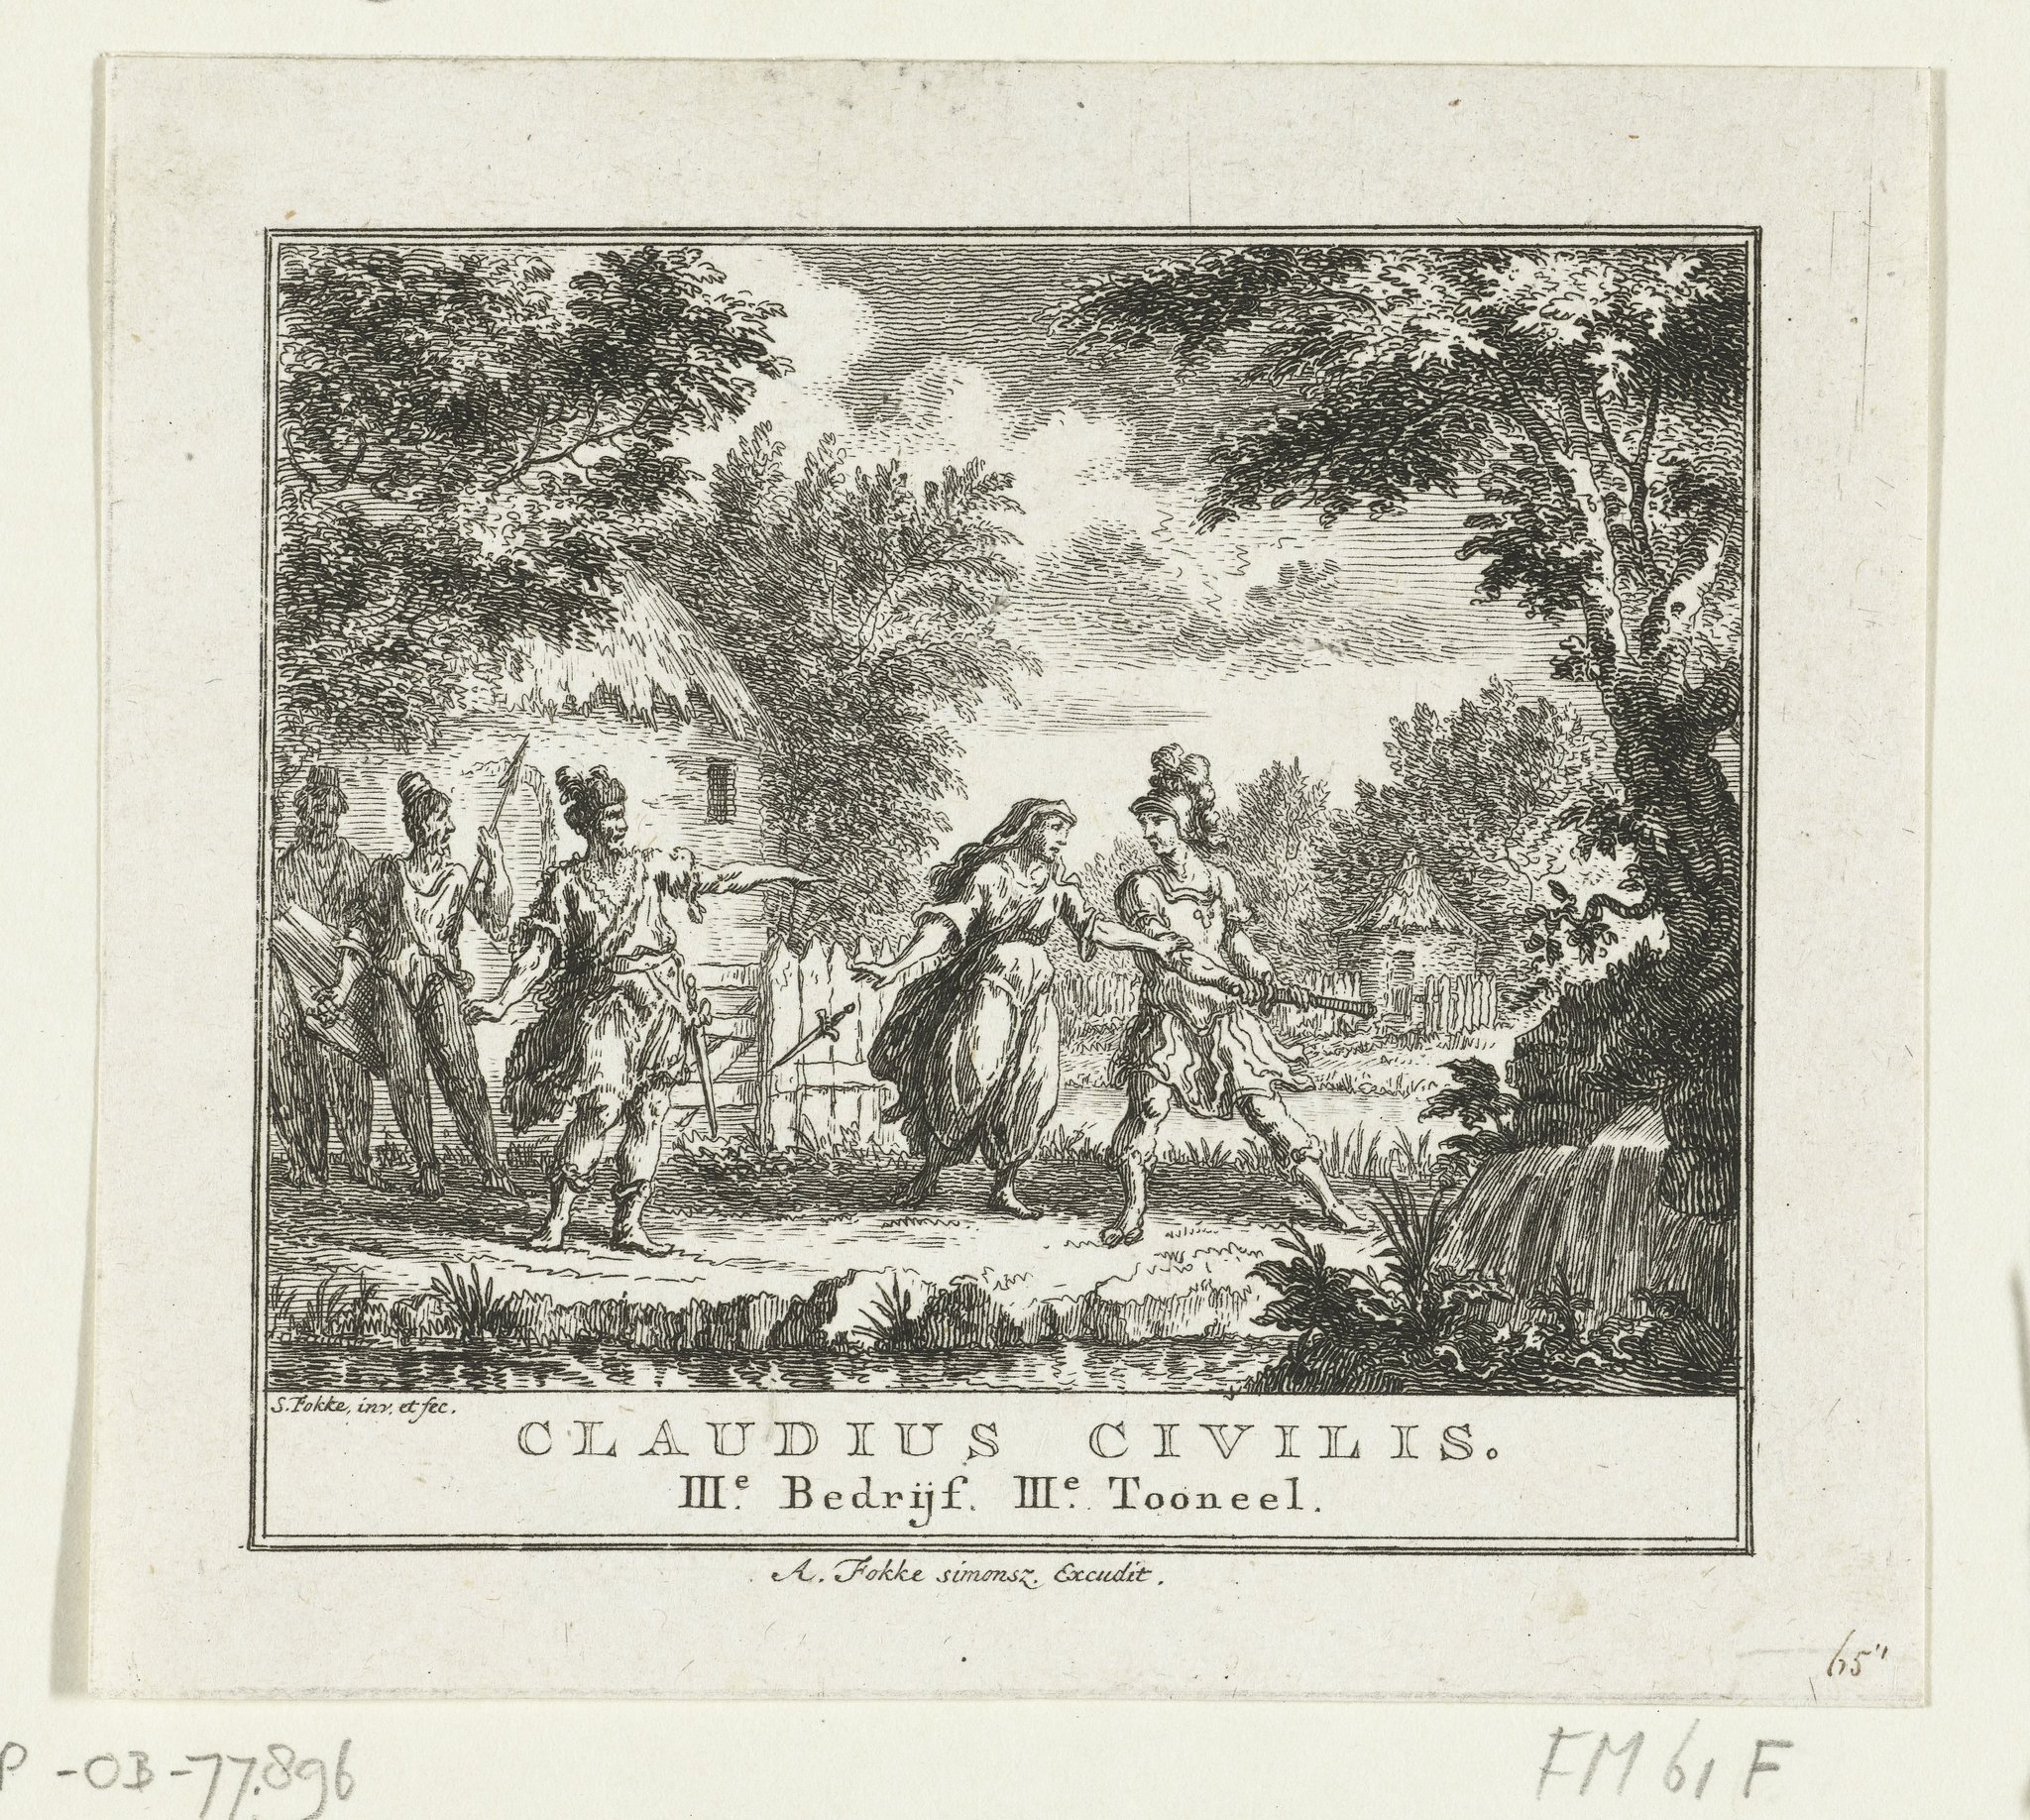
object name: history print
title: Claudius Civilis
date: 1770-1784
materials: paper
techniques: etching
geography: amsterdam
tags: extinct, 'historical' peoples (with name), netherlands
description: Illustratie voor een toneelstuk over Claudius Civilis, IIIe Bedrijf IIIe Tooneel. Niet in Frederik Muller; door het RPK toegevoegd nummer.